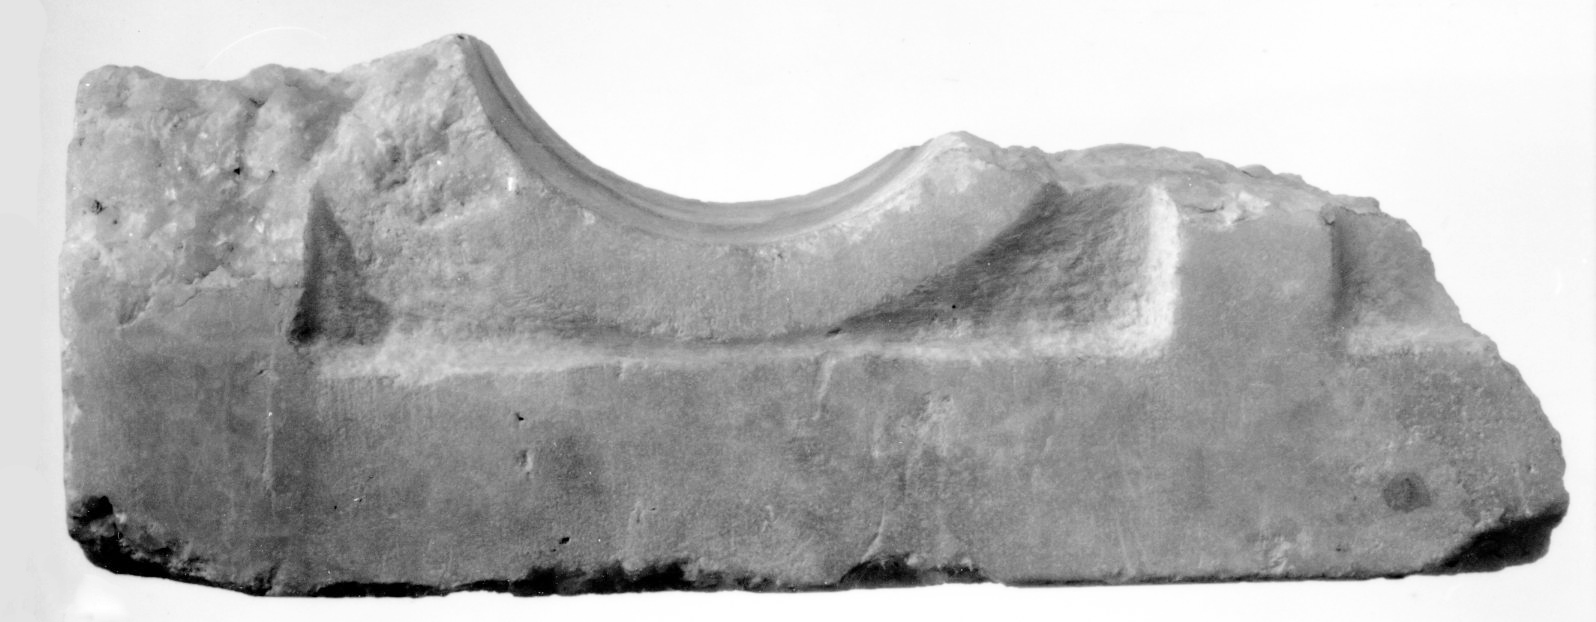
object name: canopic chest, tiye, thutmose iv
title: Fragment of a Canopic Chest of Queen Tiya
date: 1427-1390 BCE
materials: stone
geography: egypt